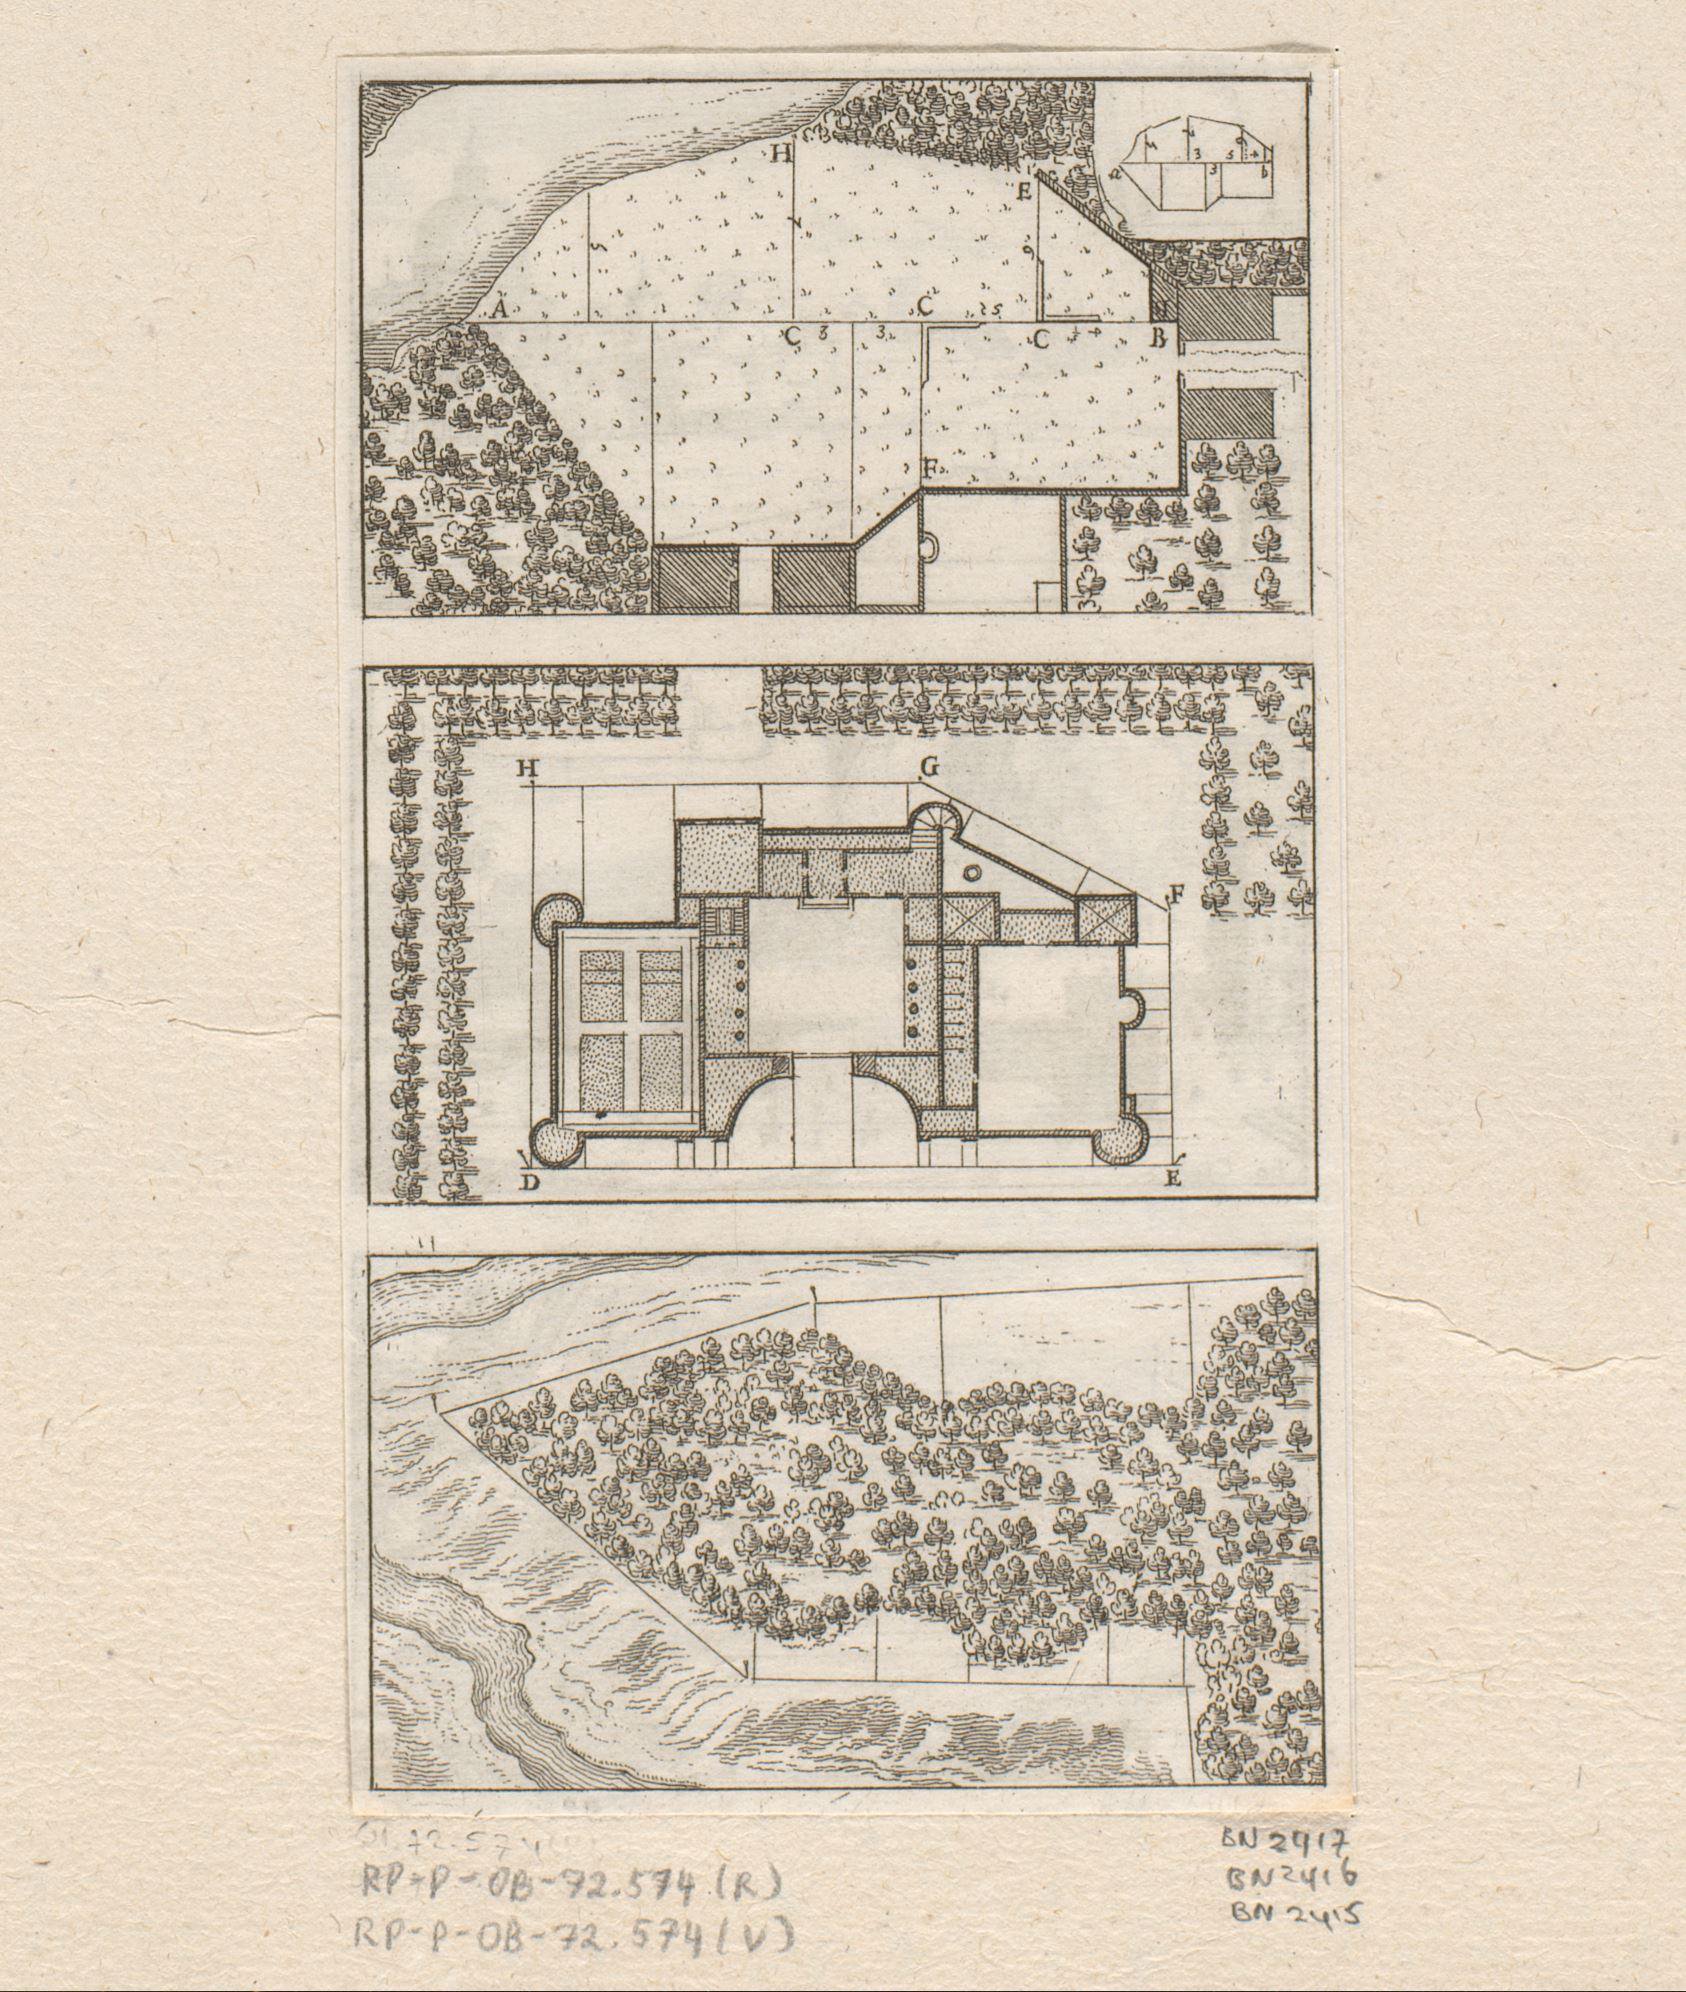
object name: print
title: Gebruik van een meetlint geïllustreerd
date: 1690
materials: paper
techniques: etching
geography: france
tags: planimetry, geometry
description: Prent uit: Leclerc, Sébastien. Traité de géométrie (...). Parijs: Jean Jombert, 1690.